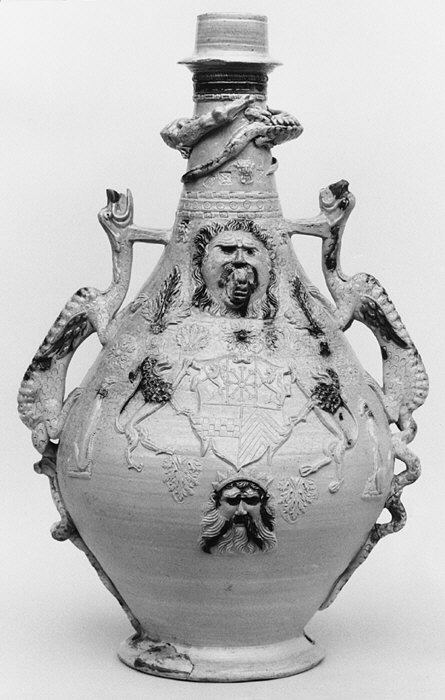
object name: pilgrim bottle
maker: anno knuetgen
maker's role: maker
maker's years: 1490-1590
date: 1573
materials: stoneware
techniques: salt glaze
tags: faces,dragons,coat of arms